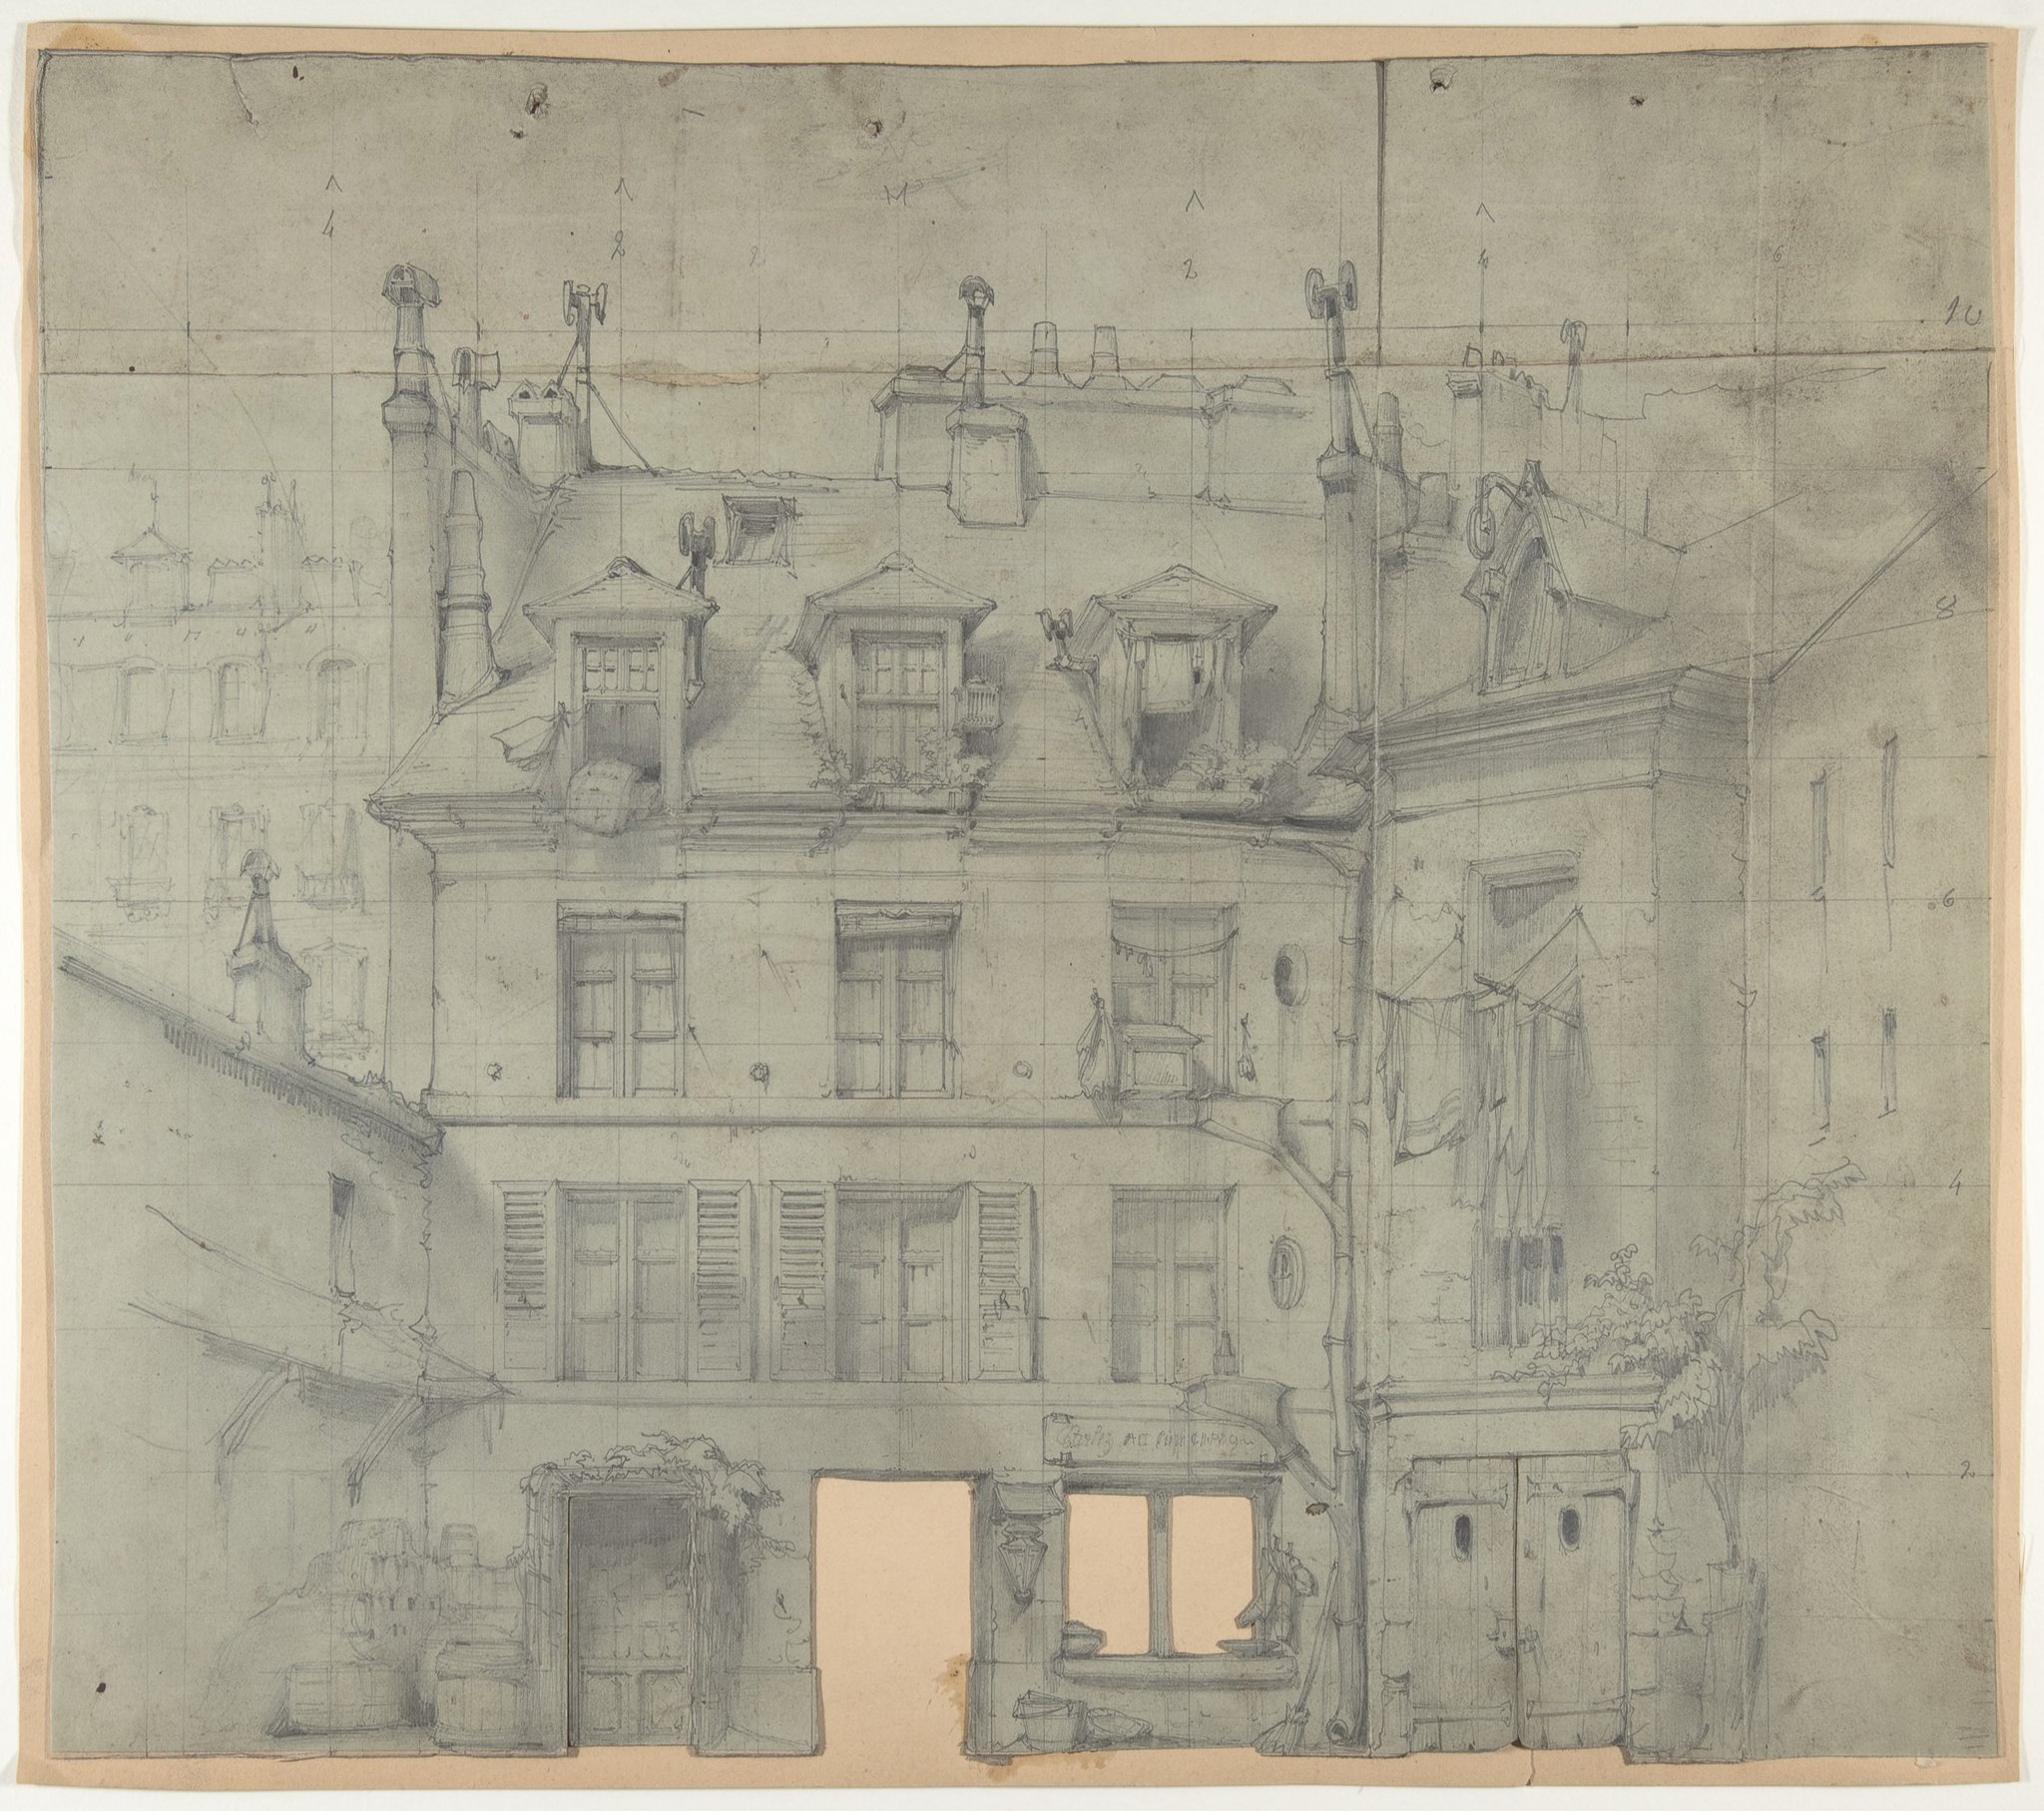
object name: drawing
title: Design for a Stage Set at the Opéra, Paris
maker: eugène cicéri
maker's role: artist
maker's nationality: french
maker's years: 1813-1890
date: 1840-1890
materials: graphite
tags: buildings,stage design